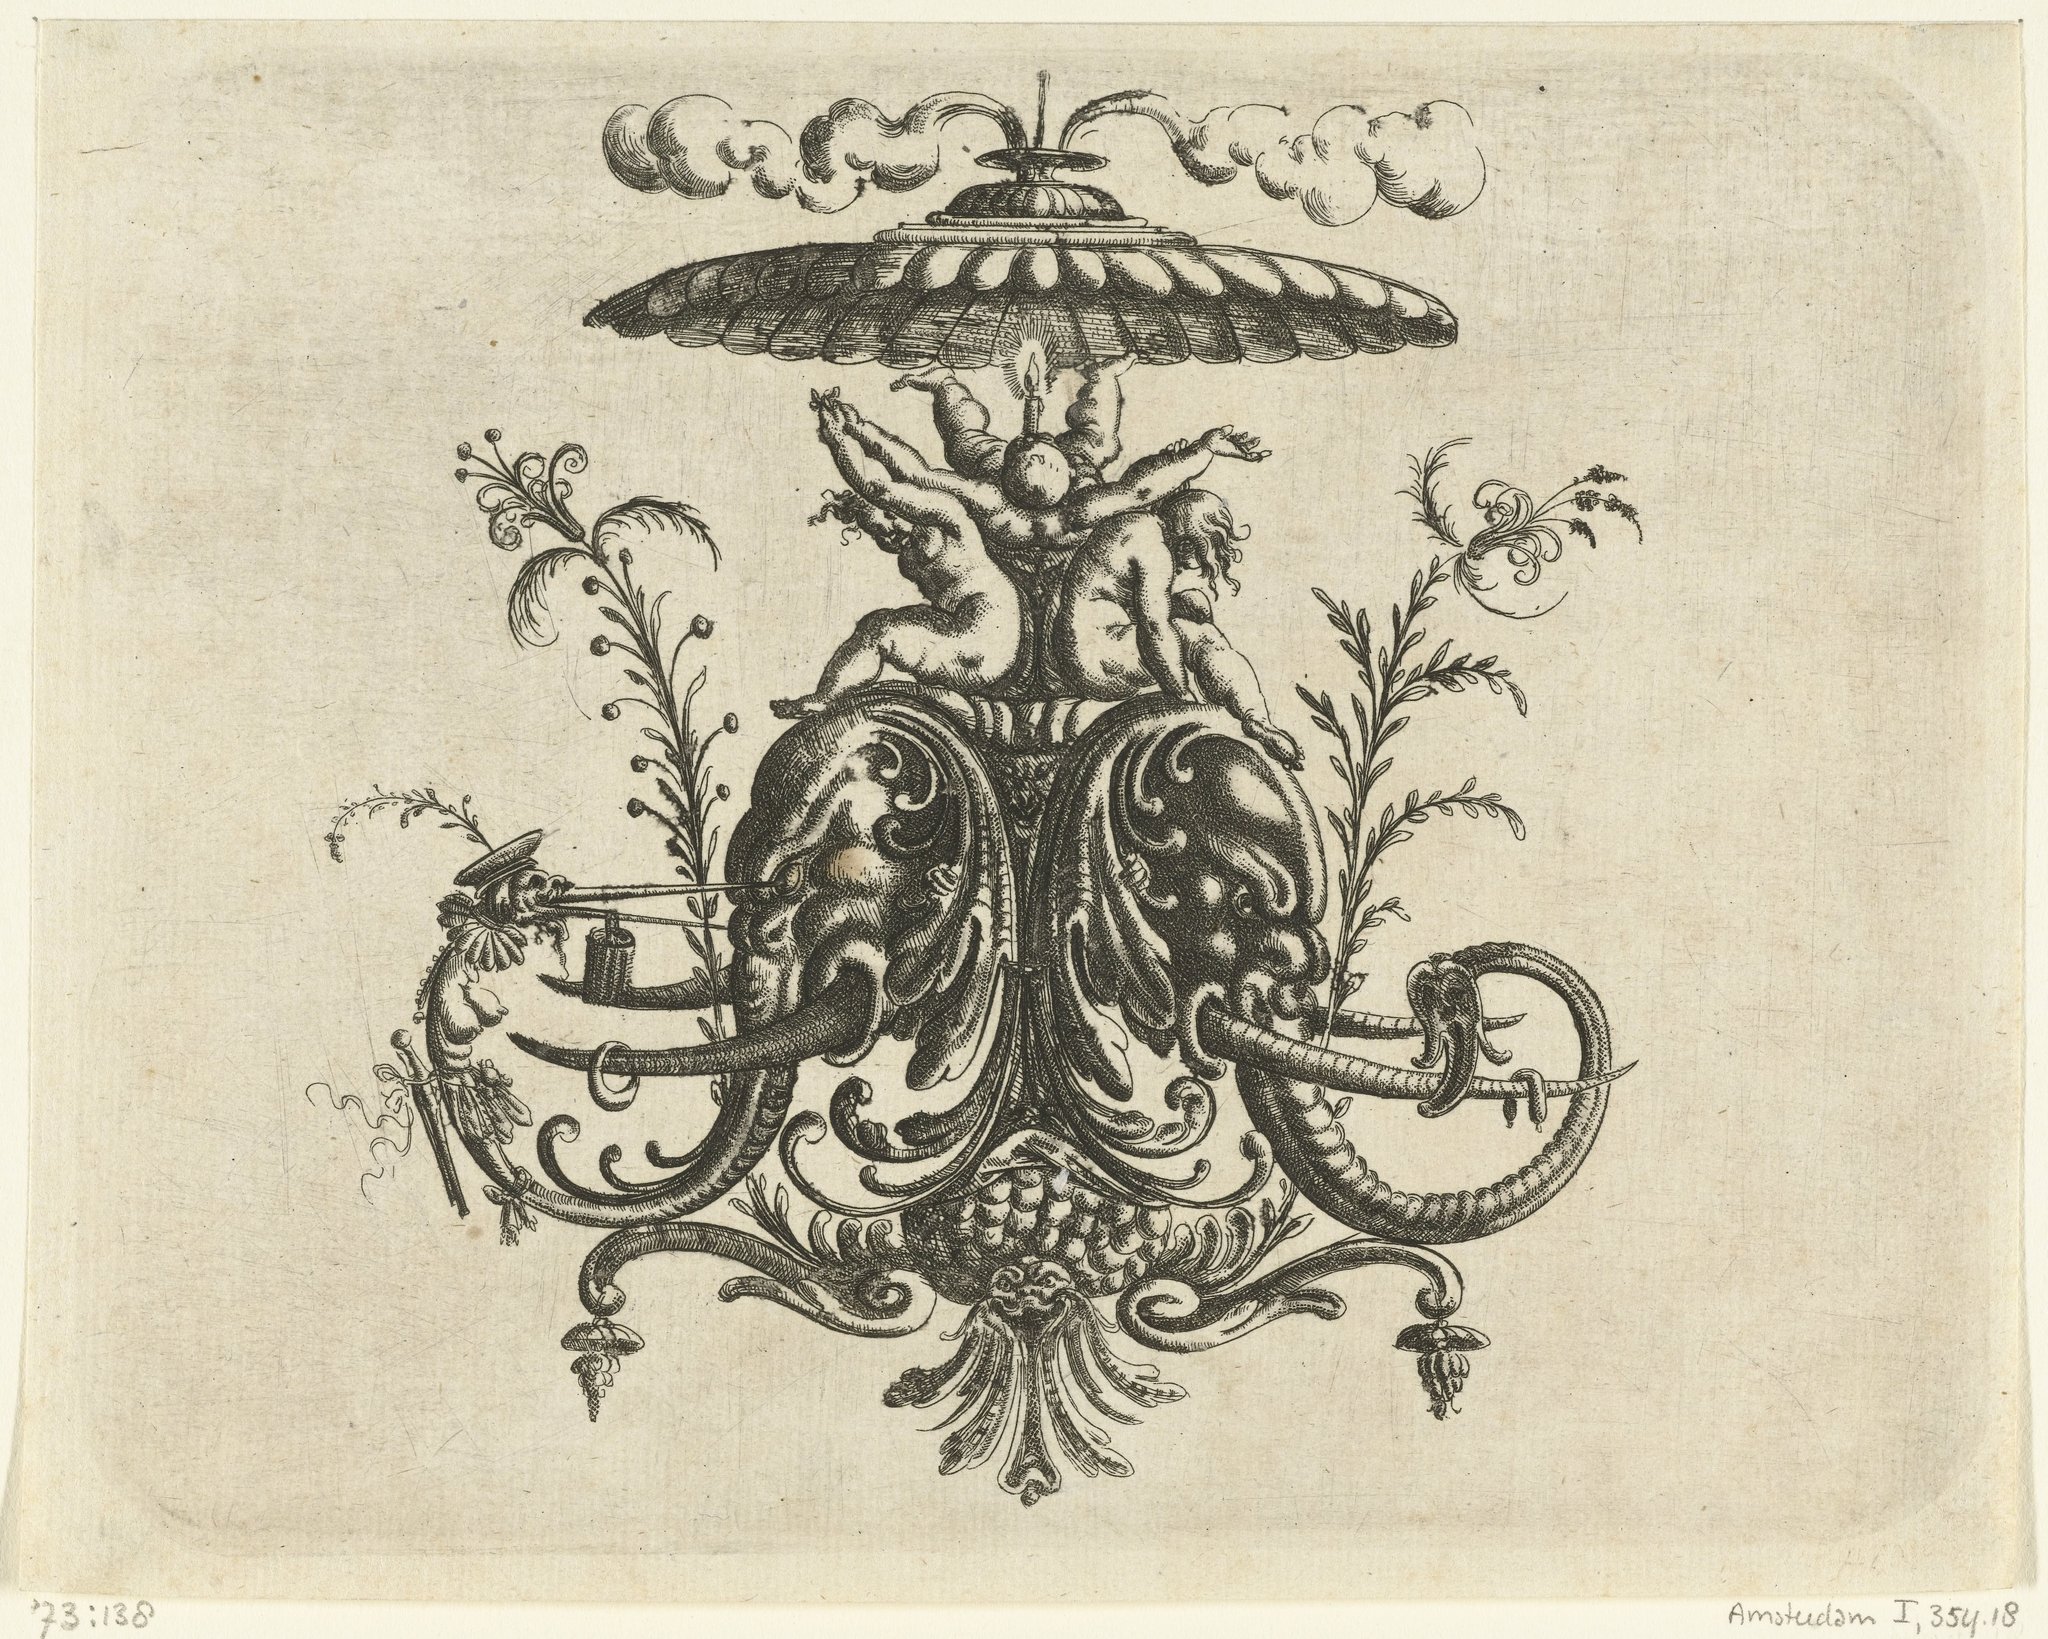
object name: print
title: blad van het "Neu Grotesken Buch" 1610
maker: christoph jamnitzer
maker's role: draughtsman, goldsmith, print maker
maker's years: 1563-1618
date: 1573-1610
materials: paper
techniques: etching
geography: germany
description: Op de console zitten rug aan rug twee kinderen. Een derde ligt op hun schouders met zijn benen omhoog. Hij heeft een brandende kaars in zijn mond. Blad uit een serie vlakdecoraties met grotesken, cartouches, ovalen, mascarons, putti en fantastische wezens. De serie bestaat uit drie titelbladen, twee tekstbladen met de opdracht en het voorwoord en 60 bladen, verdeeld over drie boeken.